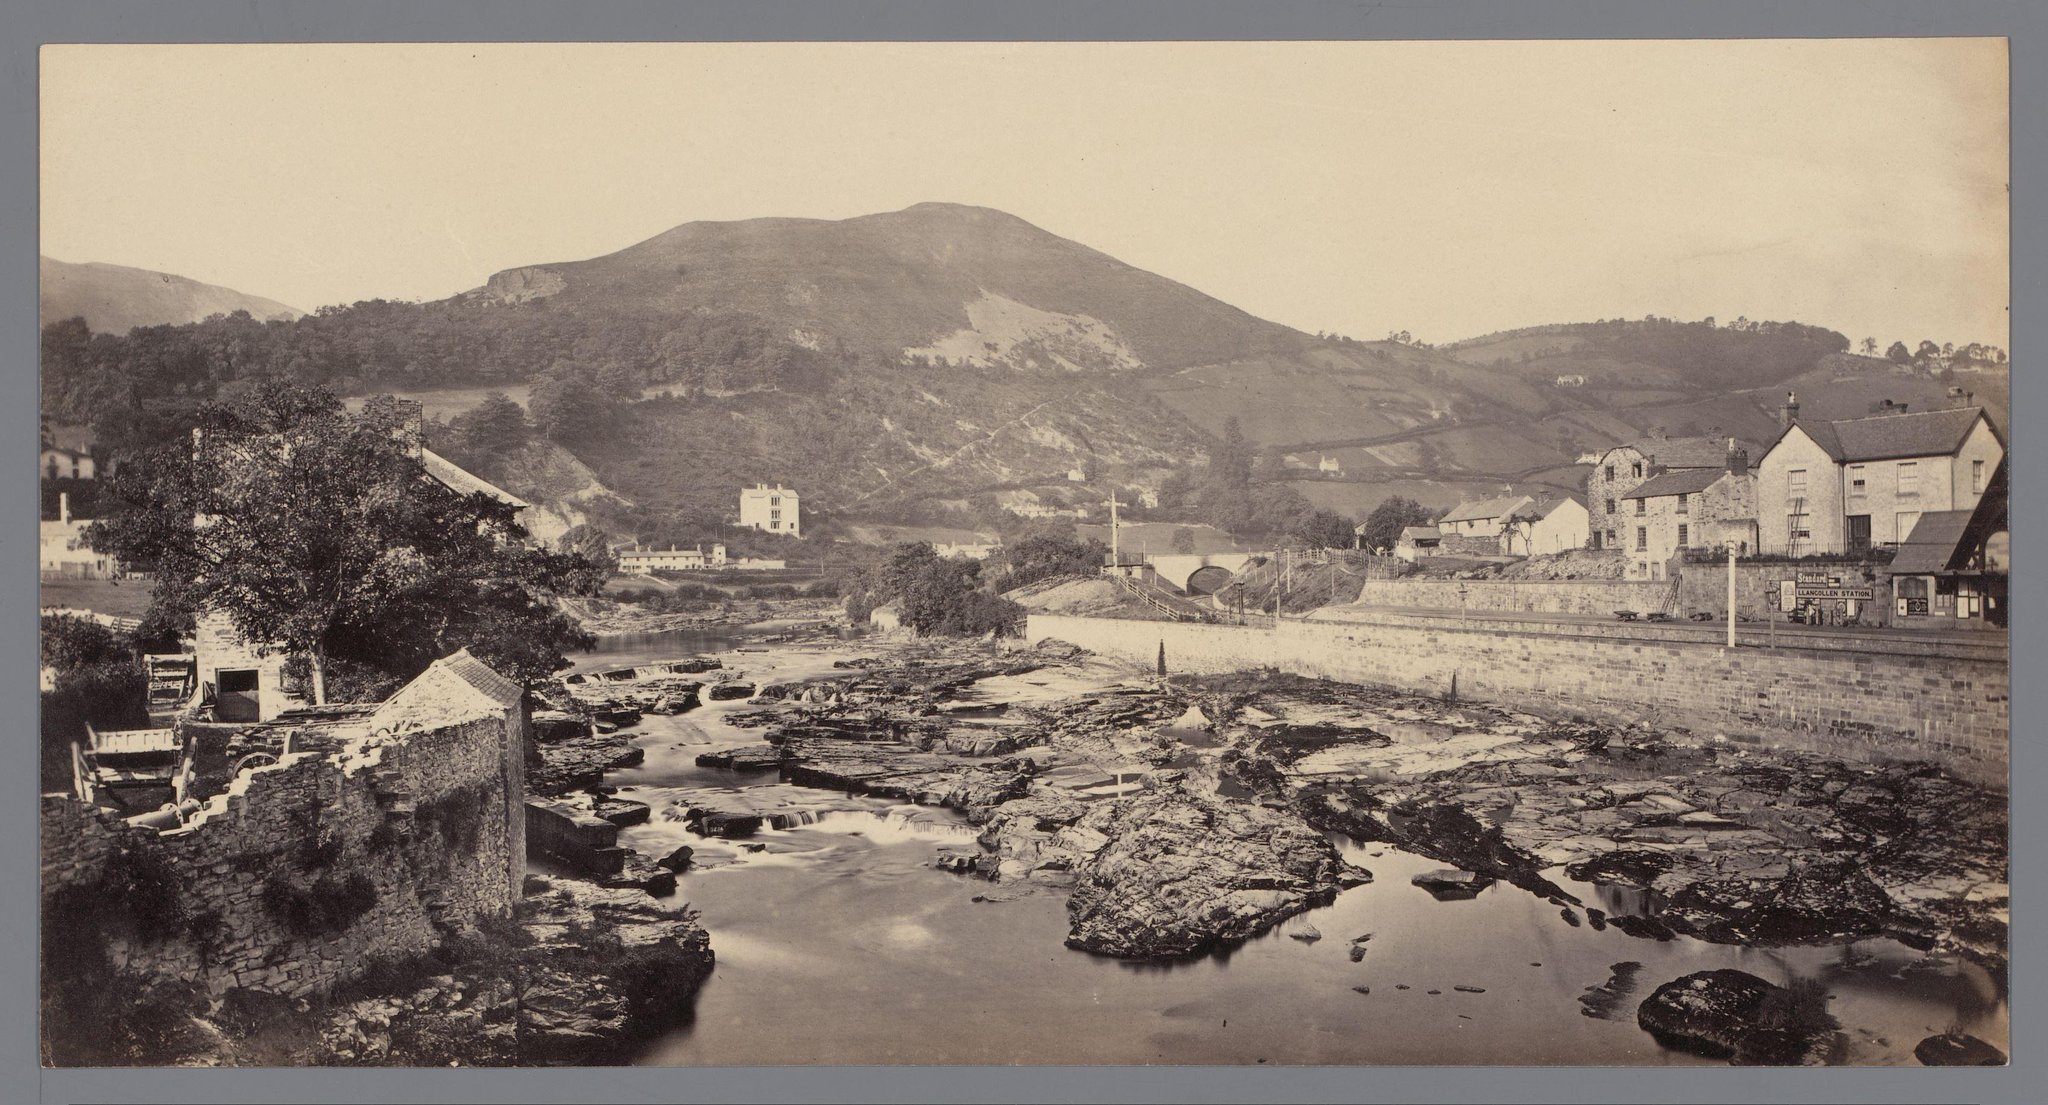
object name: photograph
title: Station van Llangollen en rivier de Dee, Denbighshire, Wales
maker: Anonymous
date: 1890-1920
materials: paper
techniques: albumen print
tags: wales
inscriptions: inscription: ‘Llangollen Station’, number: ‘5070’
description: Llangollen ligt aan de rivier Dee in Noord-Wales. Het werd door de opening van de spoorweg rond 1865 mogelijk om zonder over te stappen van Llangollen naar Londen te reizen per trein. Llangollen werd een populaire vakantiebestemming in de negentiende eeuw. Tegenwoordig een toeristische spoorweg. Foto genomen vanaf Dee Bridge [?].